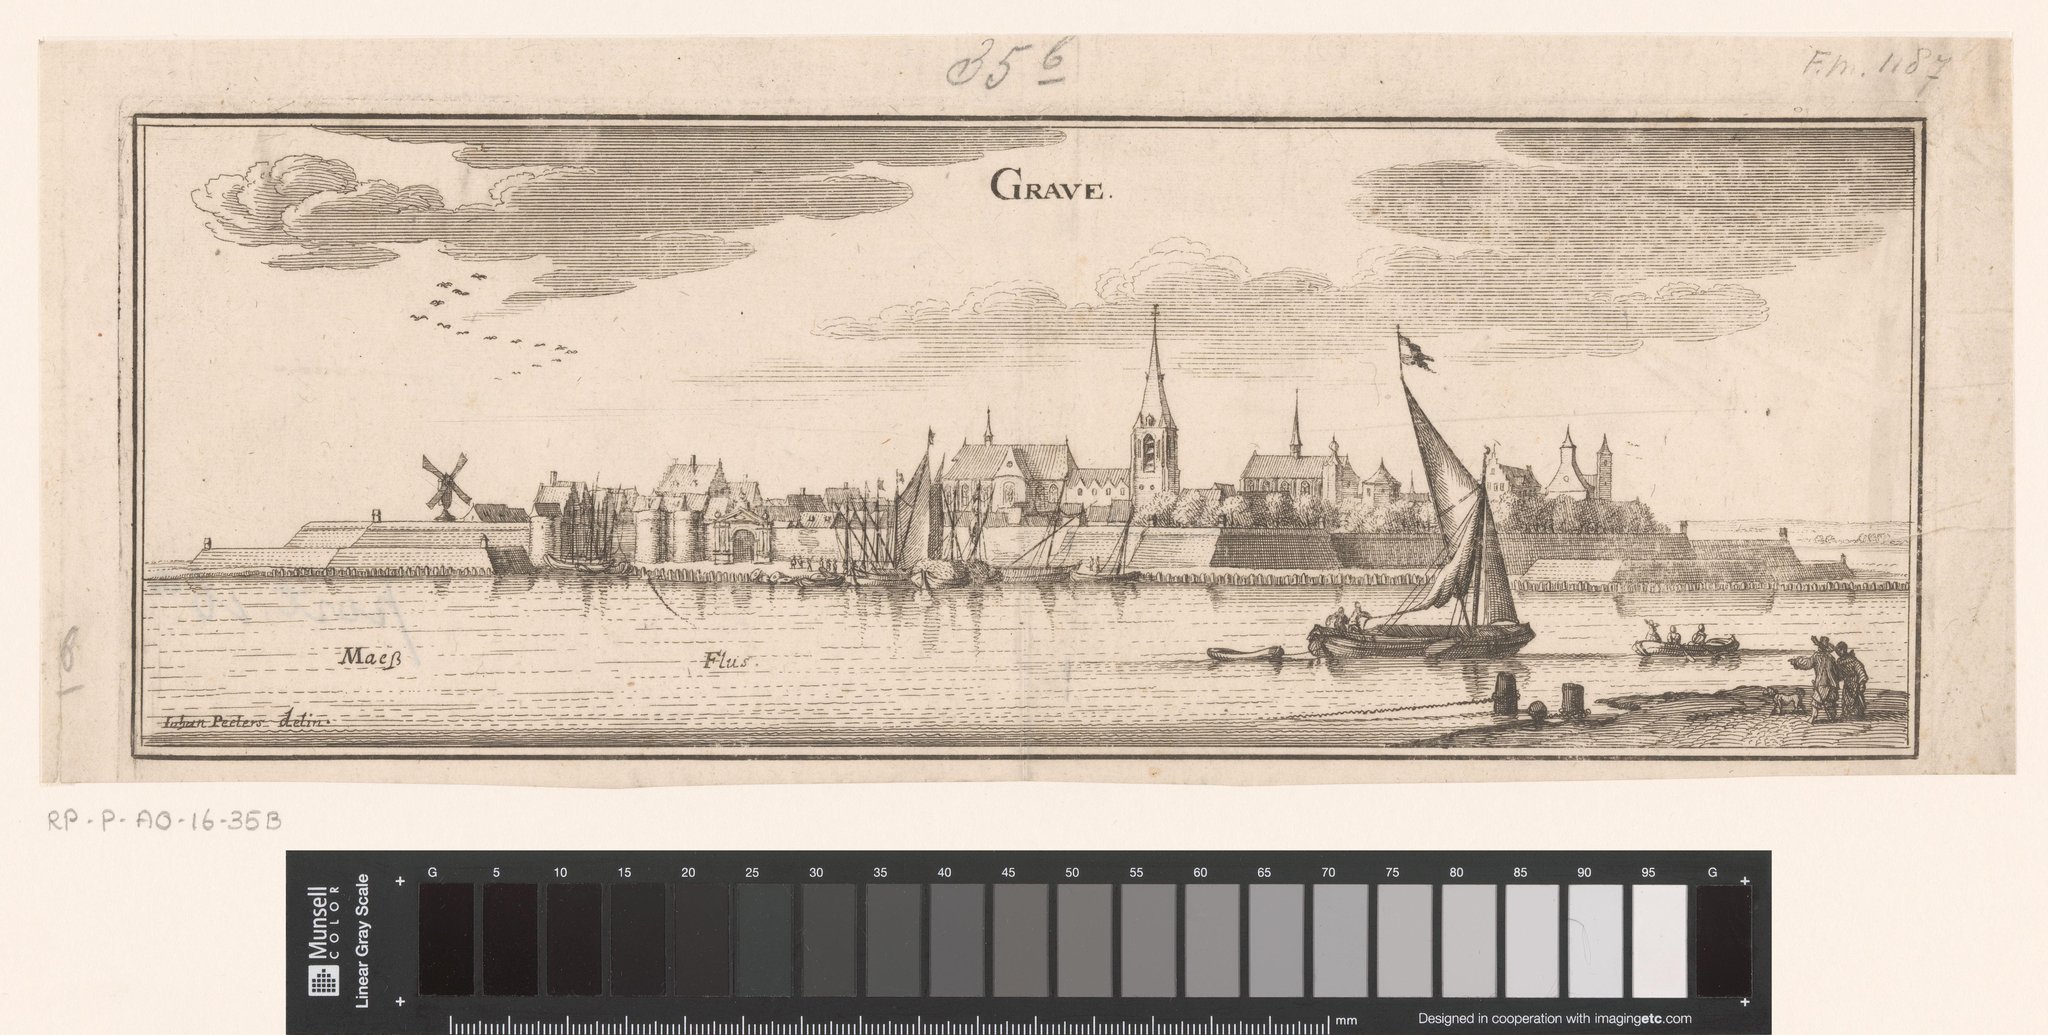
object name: print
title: Gezicht op Grave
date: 1654-1700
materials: paper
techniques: engraving, etching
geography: frankfurt am main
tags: prospect of village, silhouette of village, grave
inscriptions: collector's mark: Lugt 2228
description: Prent gebruikt in: Zeiller, Martin. M.Z. Topographia Circuli Burgundici Oder Beschreibung une Eigentliche Abbildung der Vornehmsten Örter in dem Hochlöblichen Burgund- un Niderlandischen Crayse. Frankfurt am Main: Caspar Merian, 1654. Of in: Zeiller, Martin. M. Z. Topographia Germaniae-Inferioris vel Circuli-Burgundici, das ist Beschreibung (…). Frankfurt am Main: Caspar Merian, 1659. Of in een van de twee latere uitgaven van deze publicatie die, hoewel het jaar 1659 erin staat vermeld als jaar van uitgave, zijn uitgegeven in respectievelijk ca. 1670 en ca. 1700.